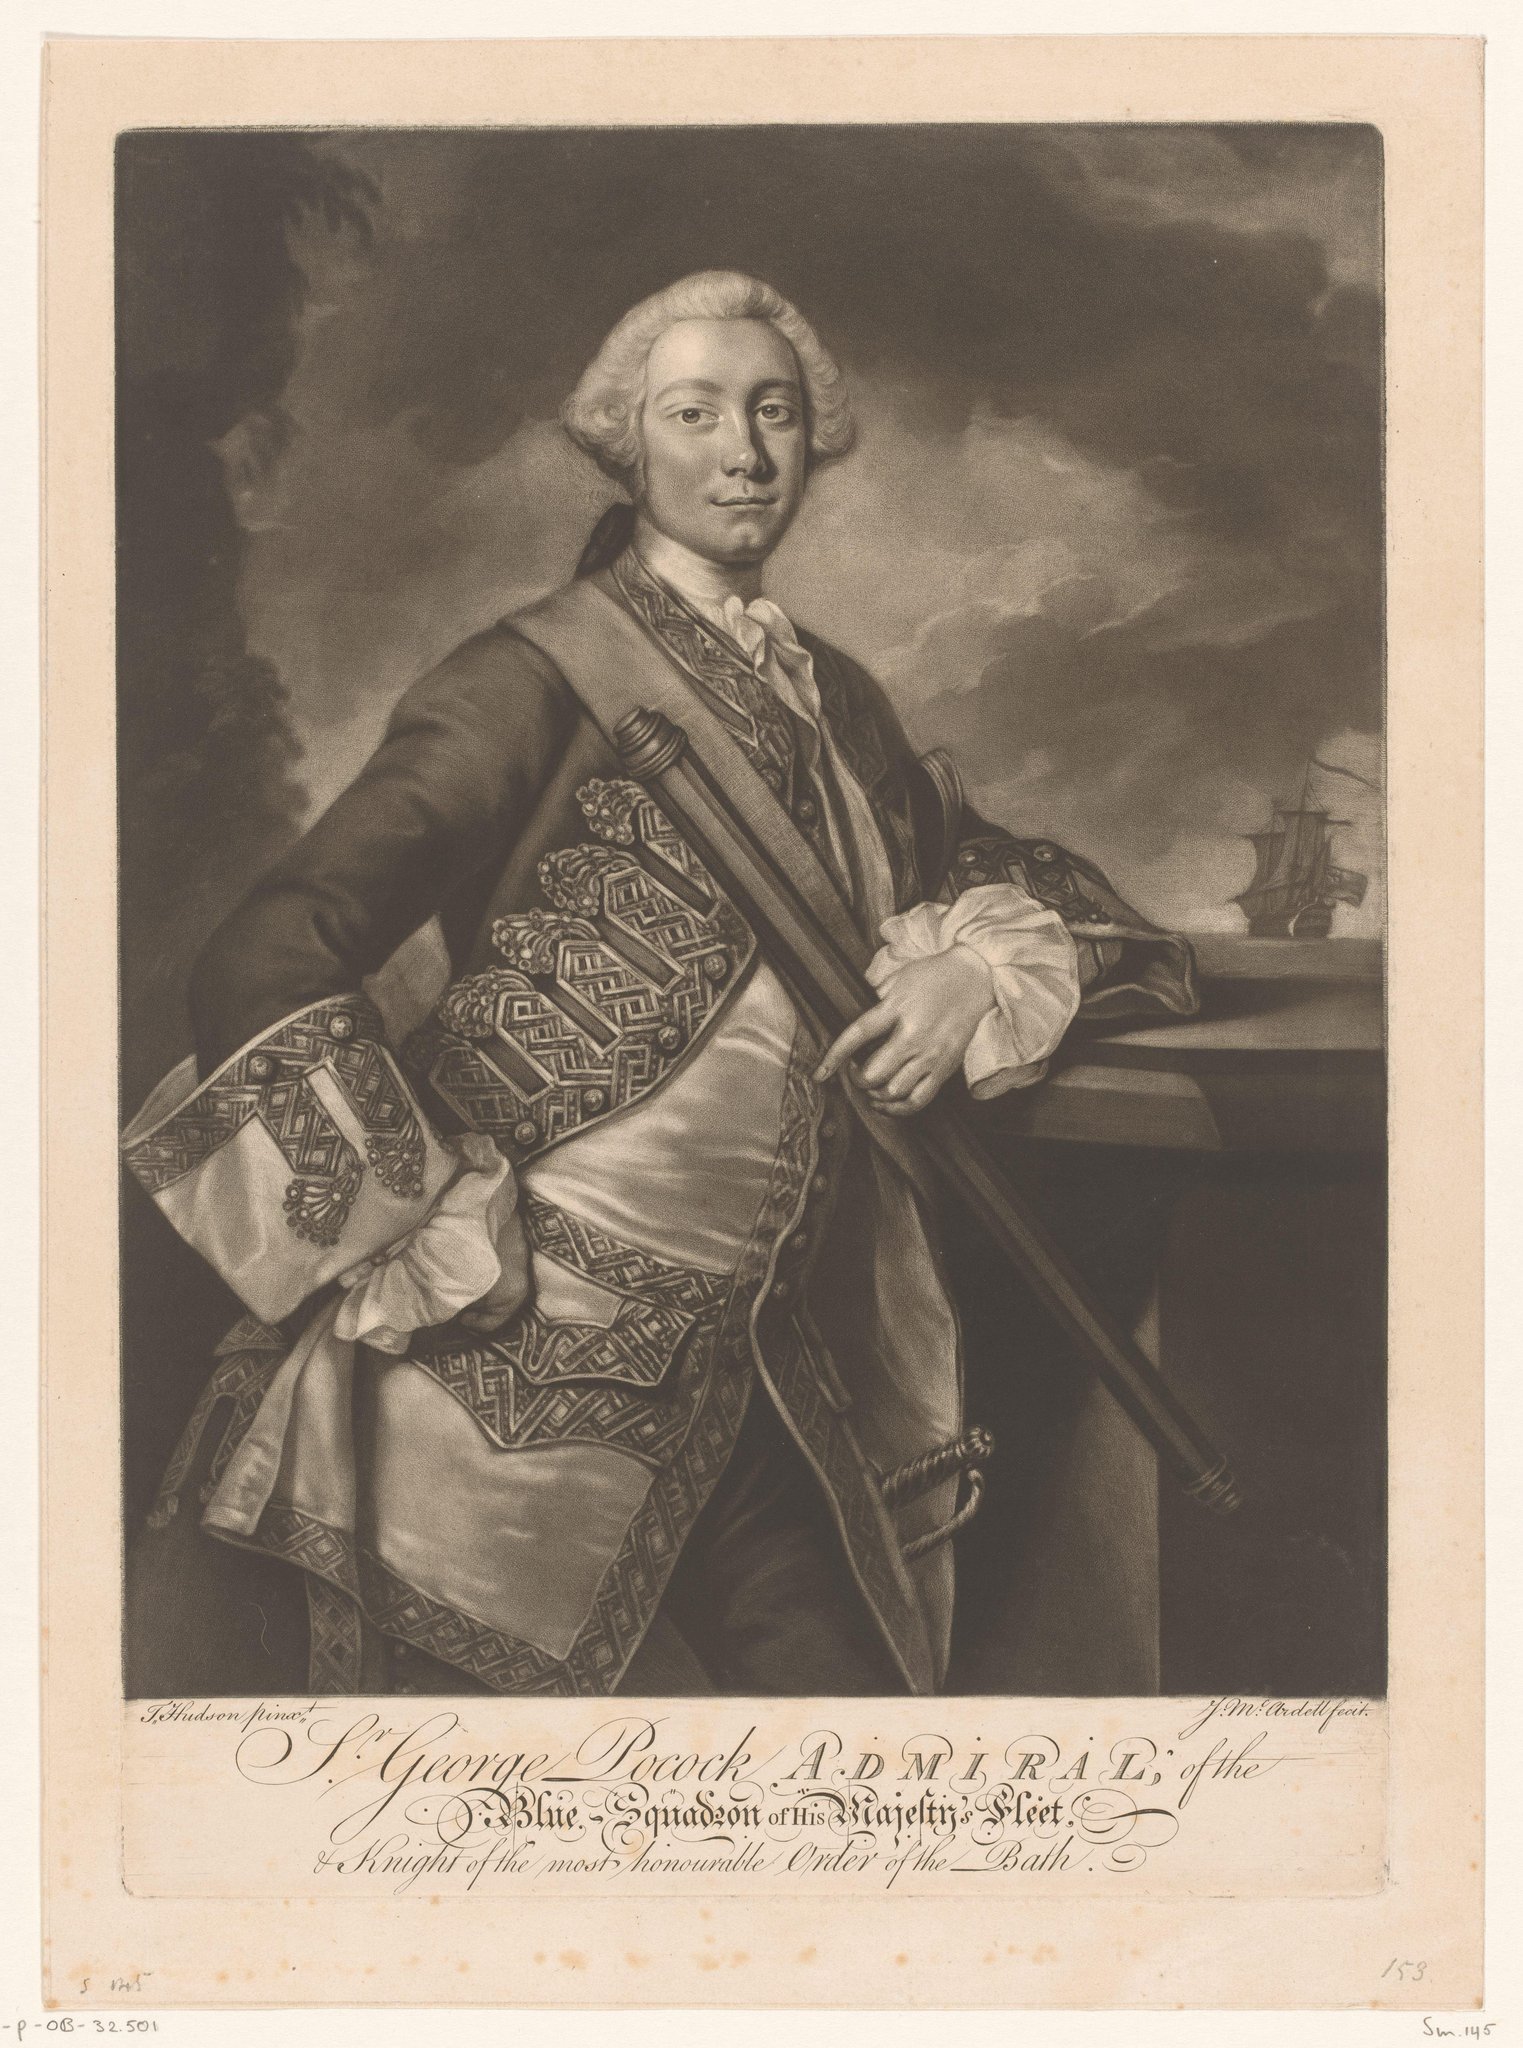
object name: print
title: Portret van George Pocock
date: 1762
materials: paper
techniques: mezzotint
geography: london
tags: historical persons, officer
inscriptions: collector's mark: Lugt 240